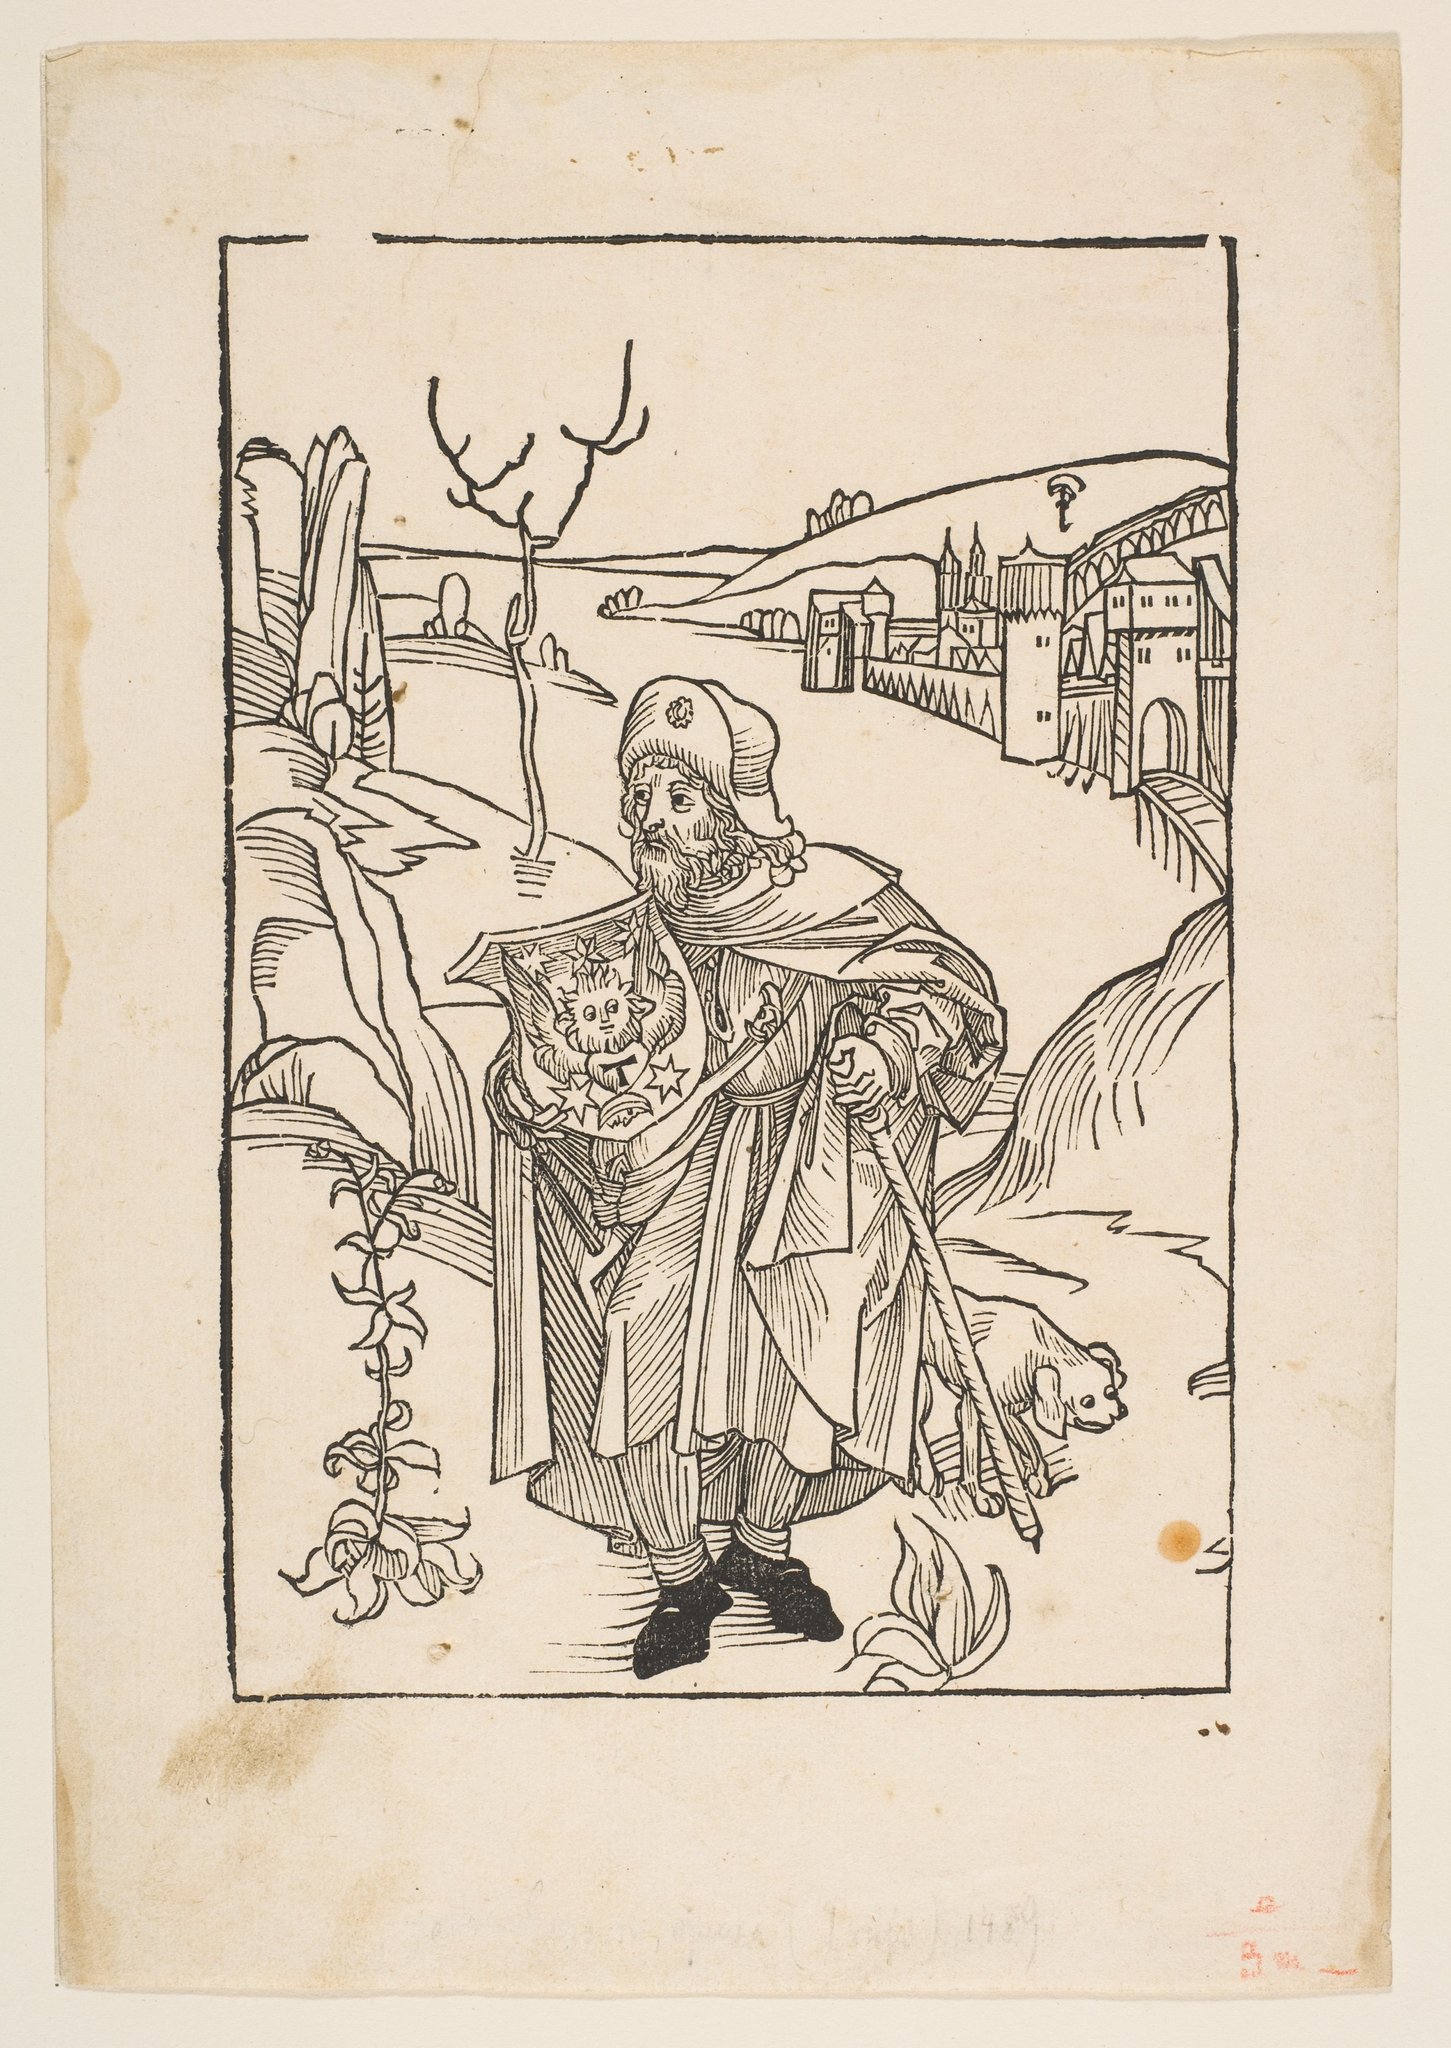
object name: print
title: Gerson as a Pilgrim, frontispiece to Gersonis Opera, 1489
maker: albrecht dürer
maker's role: artist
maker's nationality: german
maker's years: 1471-1528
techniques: woodcut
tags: buildings,shields,men,dogs,landscapes